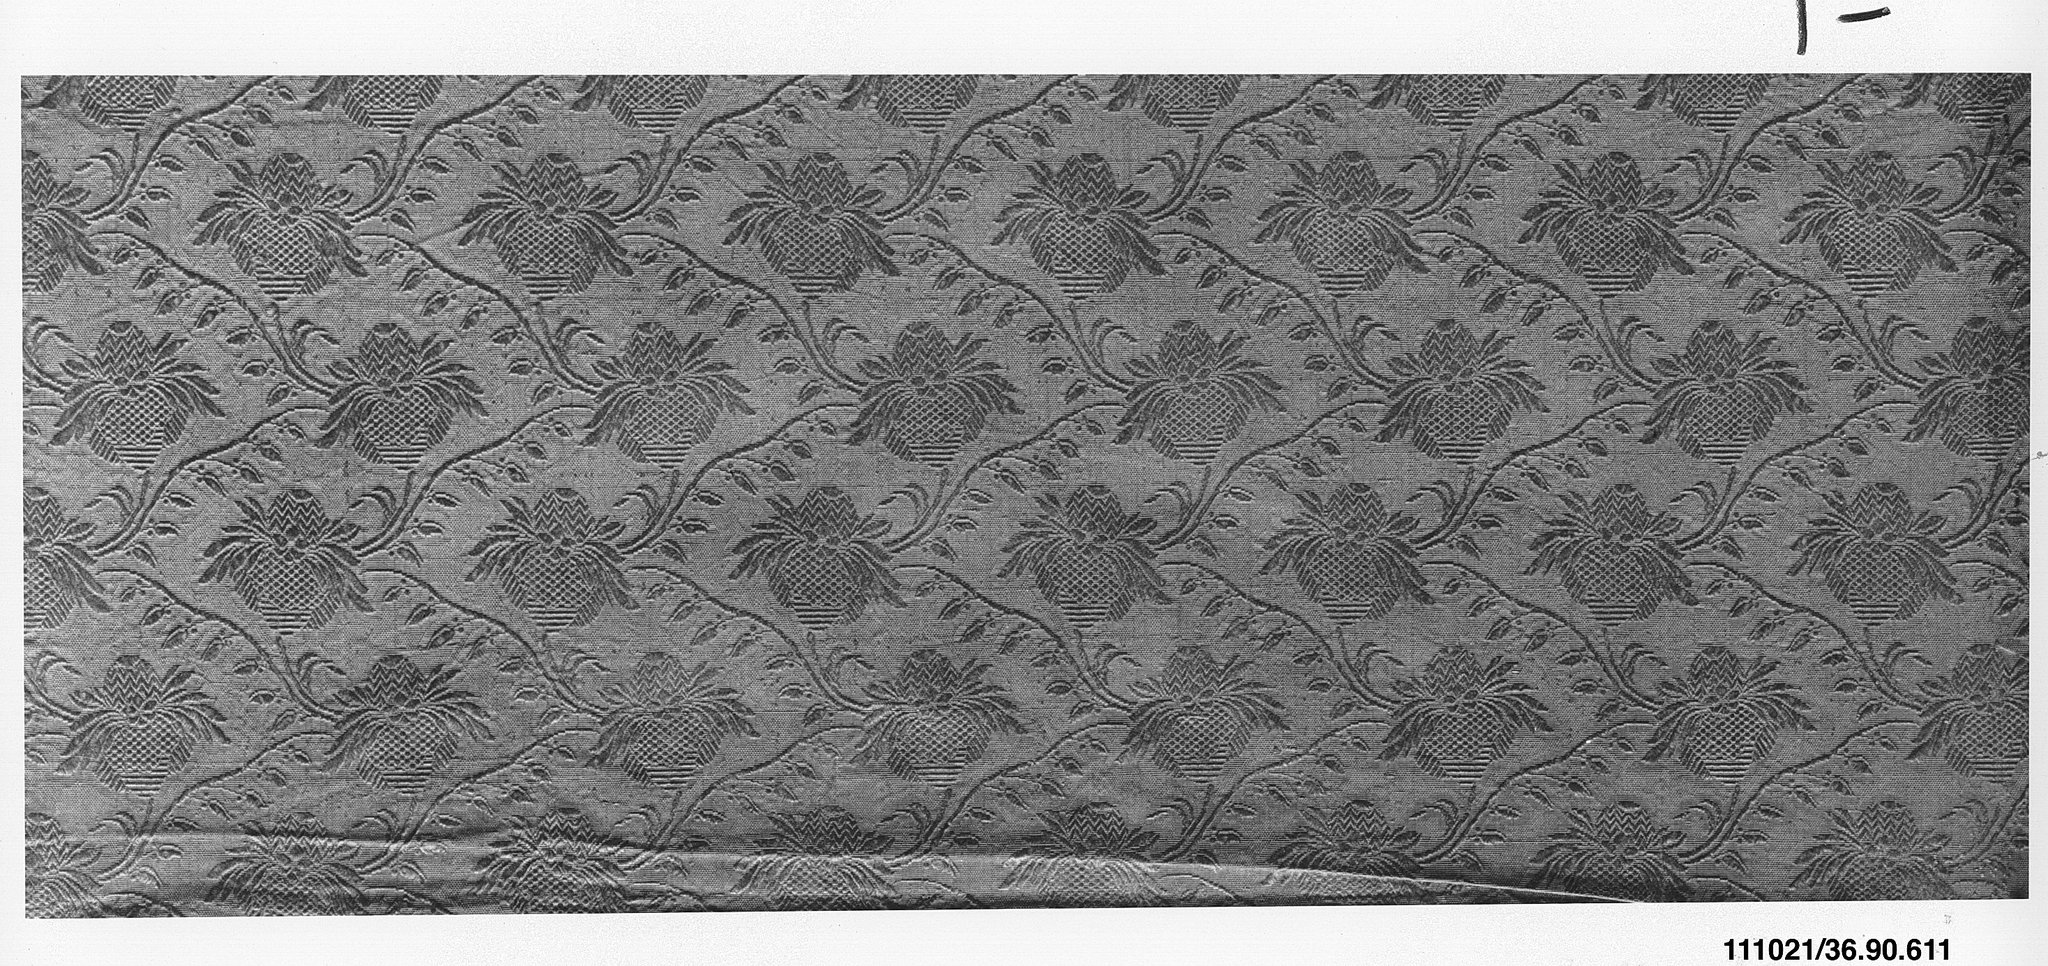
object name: piece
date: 1767-1800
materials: silk